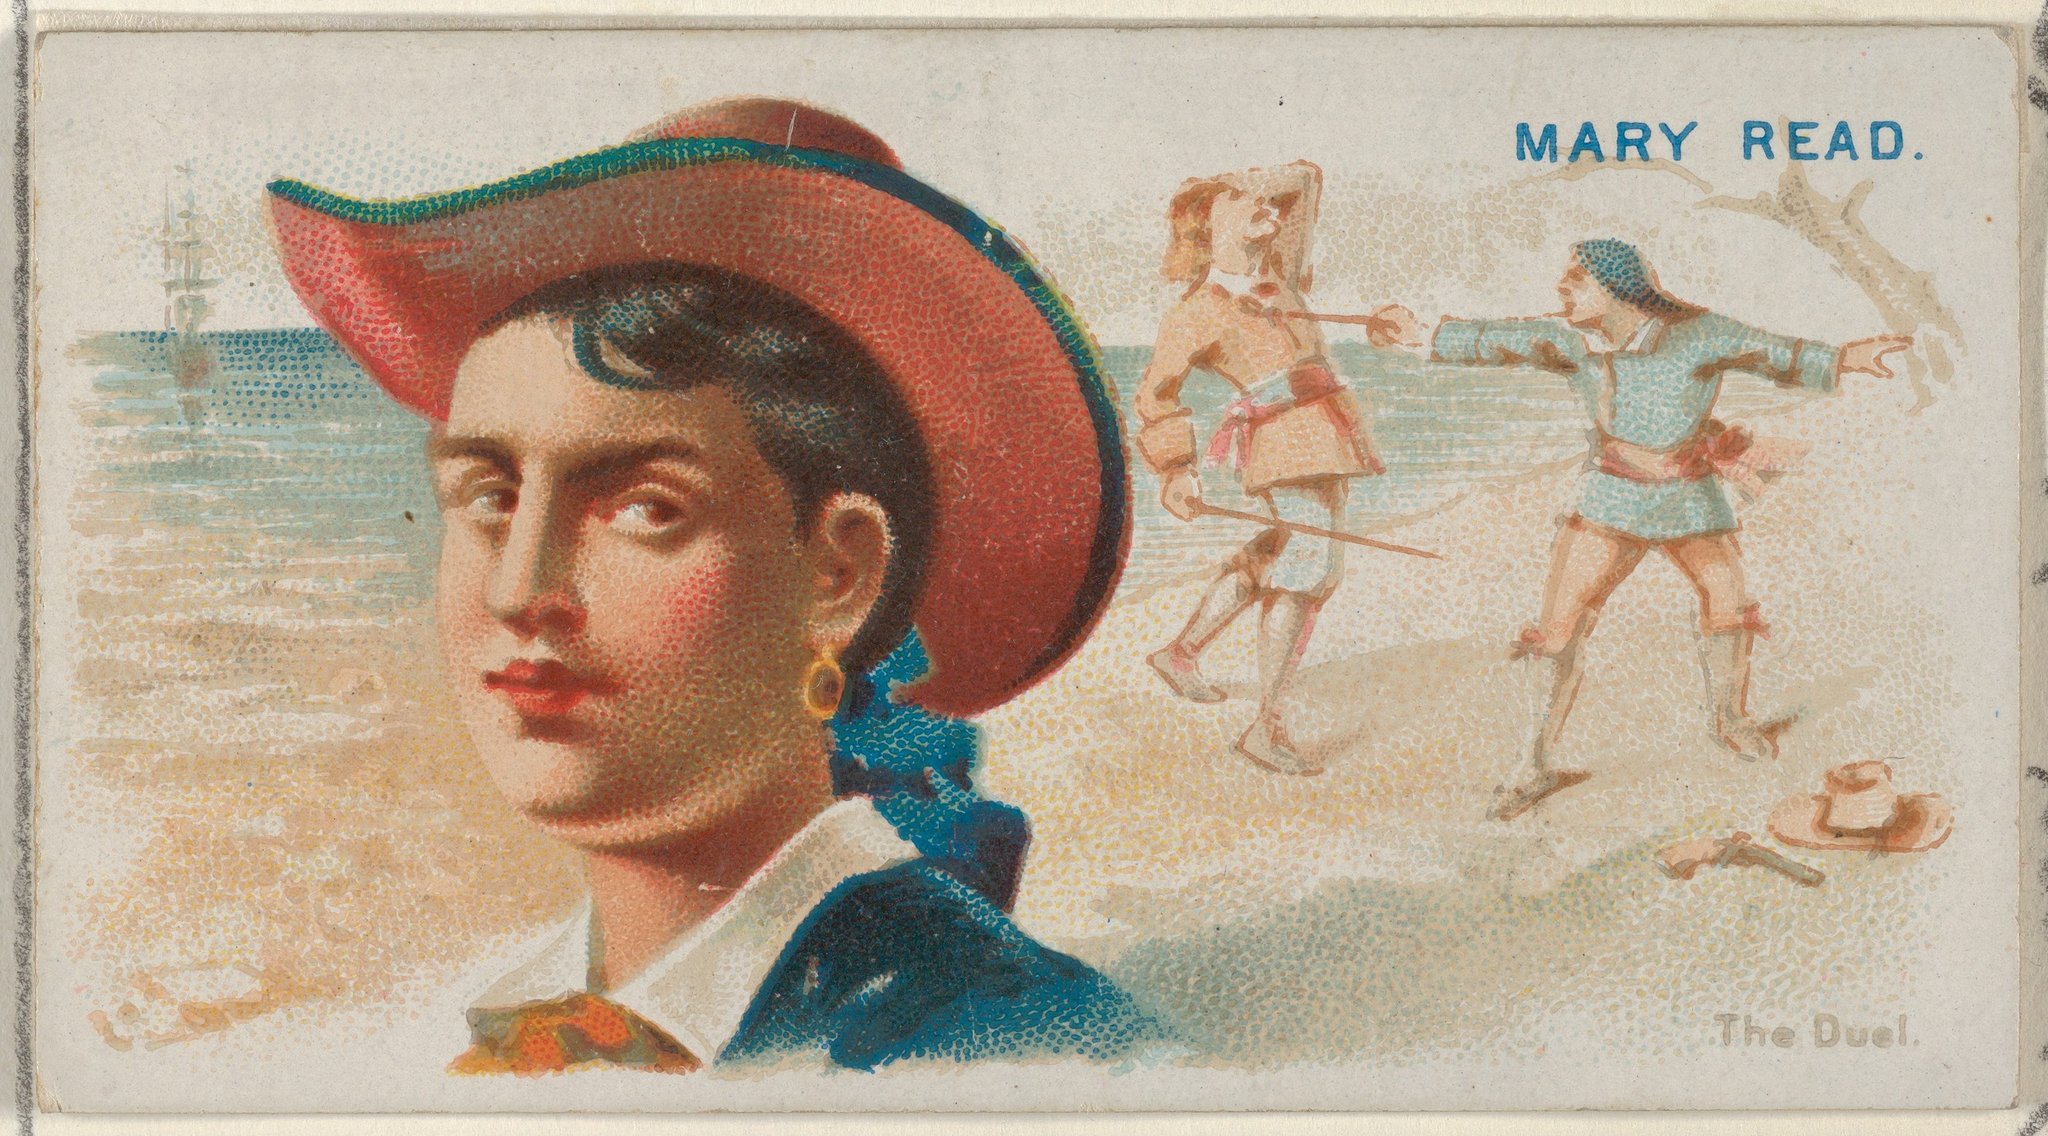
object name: print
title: Mary Read, The Duel, from the Pirates of the Spanish Main series (N19) for Allen & Ginter Cigarettes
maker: allen & ginter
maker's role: publisher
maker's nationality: american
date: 1888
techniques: color lithograph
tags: women